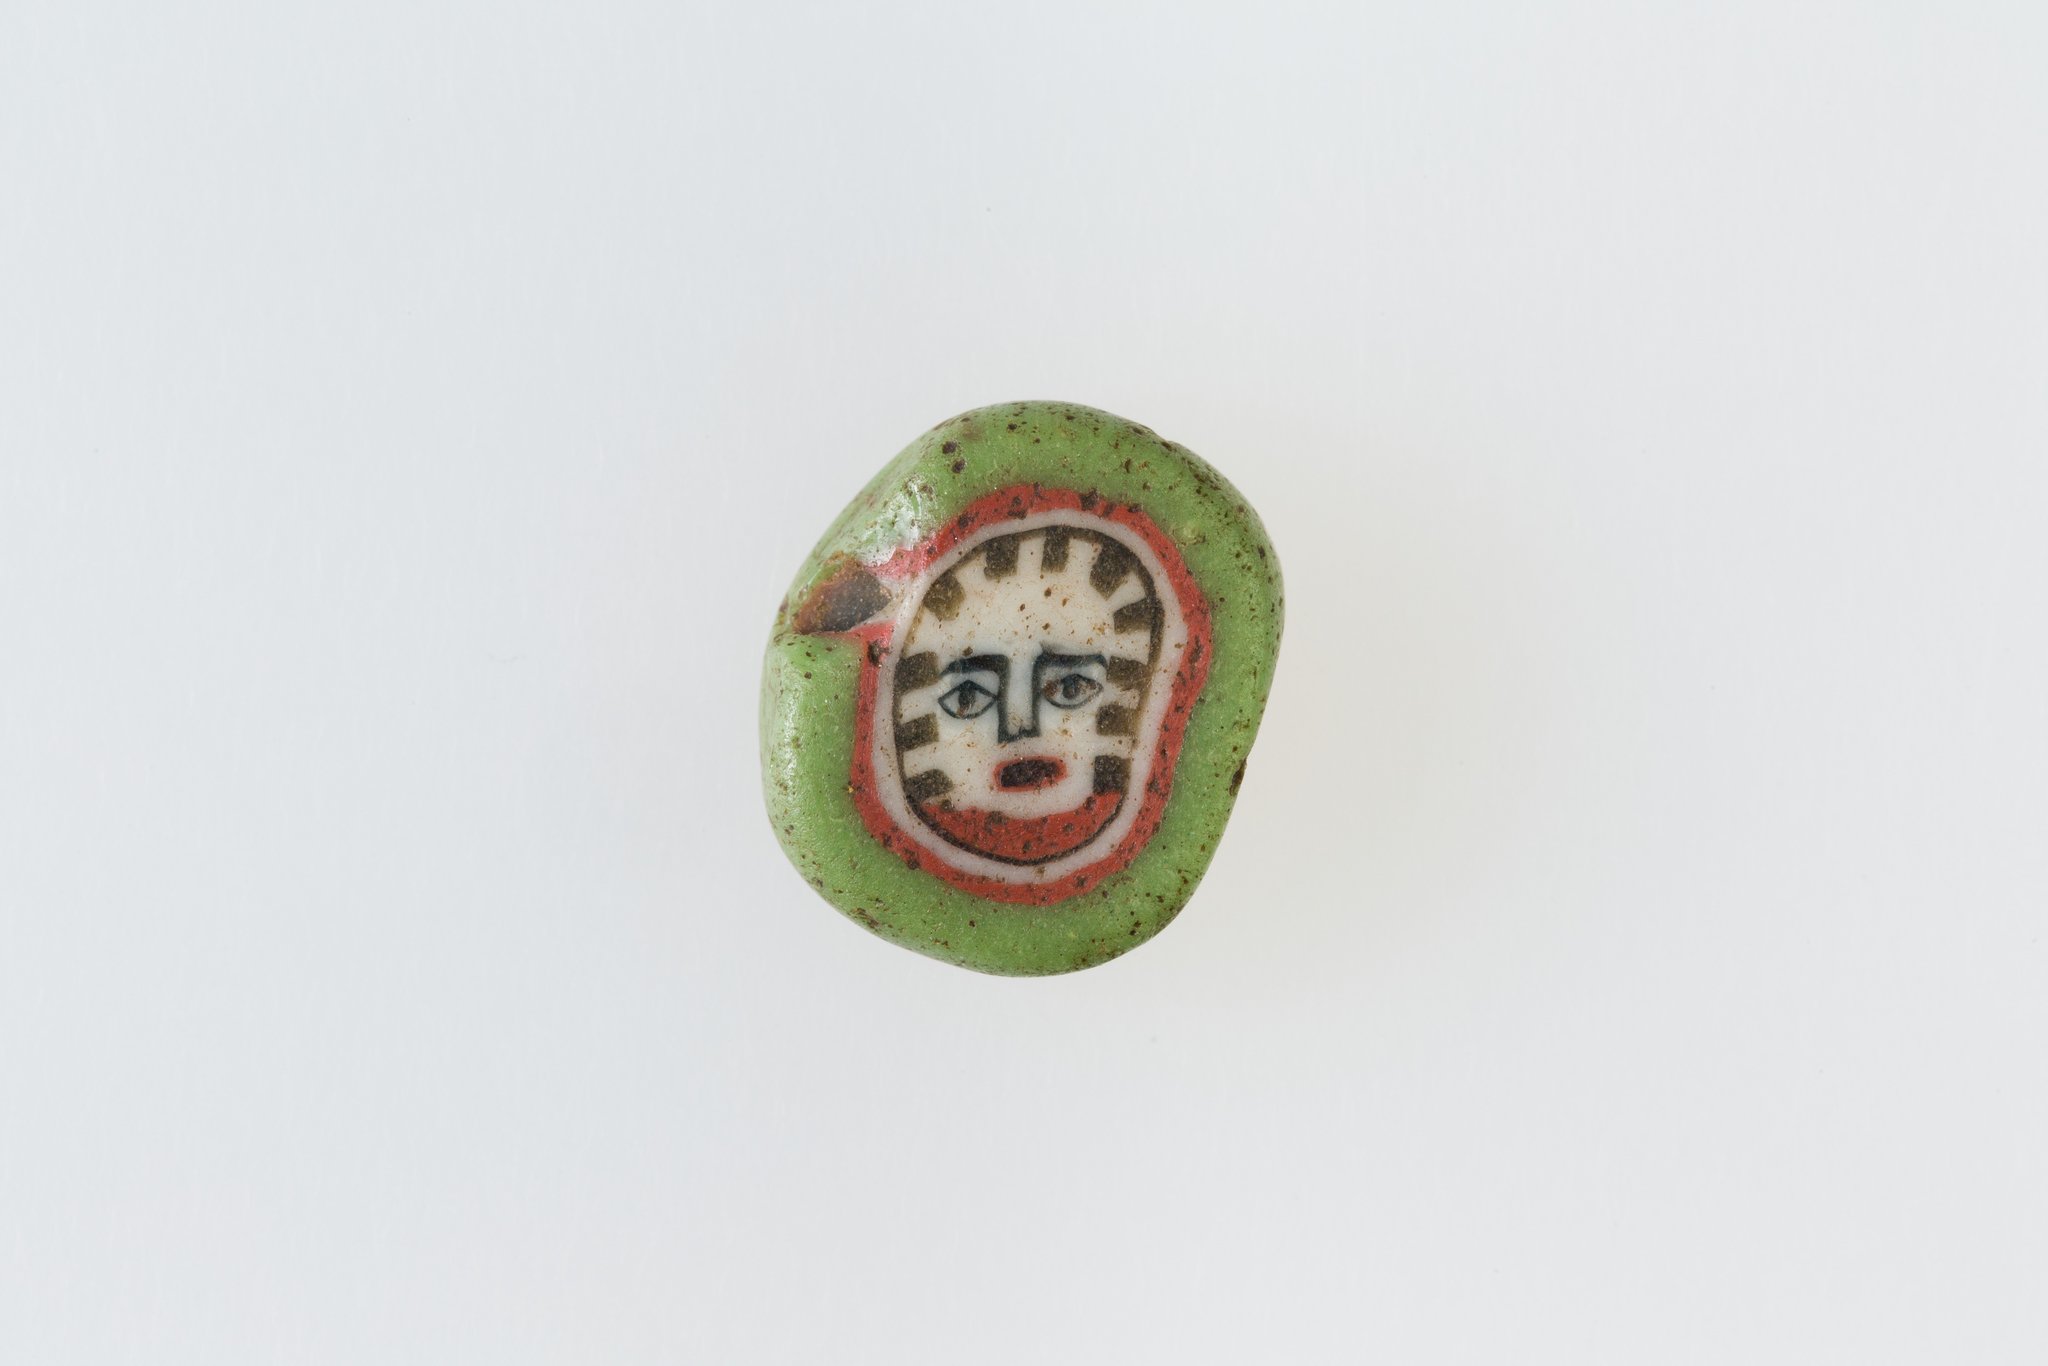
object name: inlay, face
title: Inlay / bead blank with face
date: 100 BCE-100 CE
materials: glass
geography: egypt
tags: faces